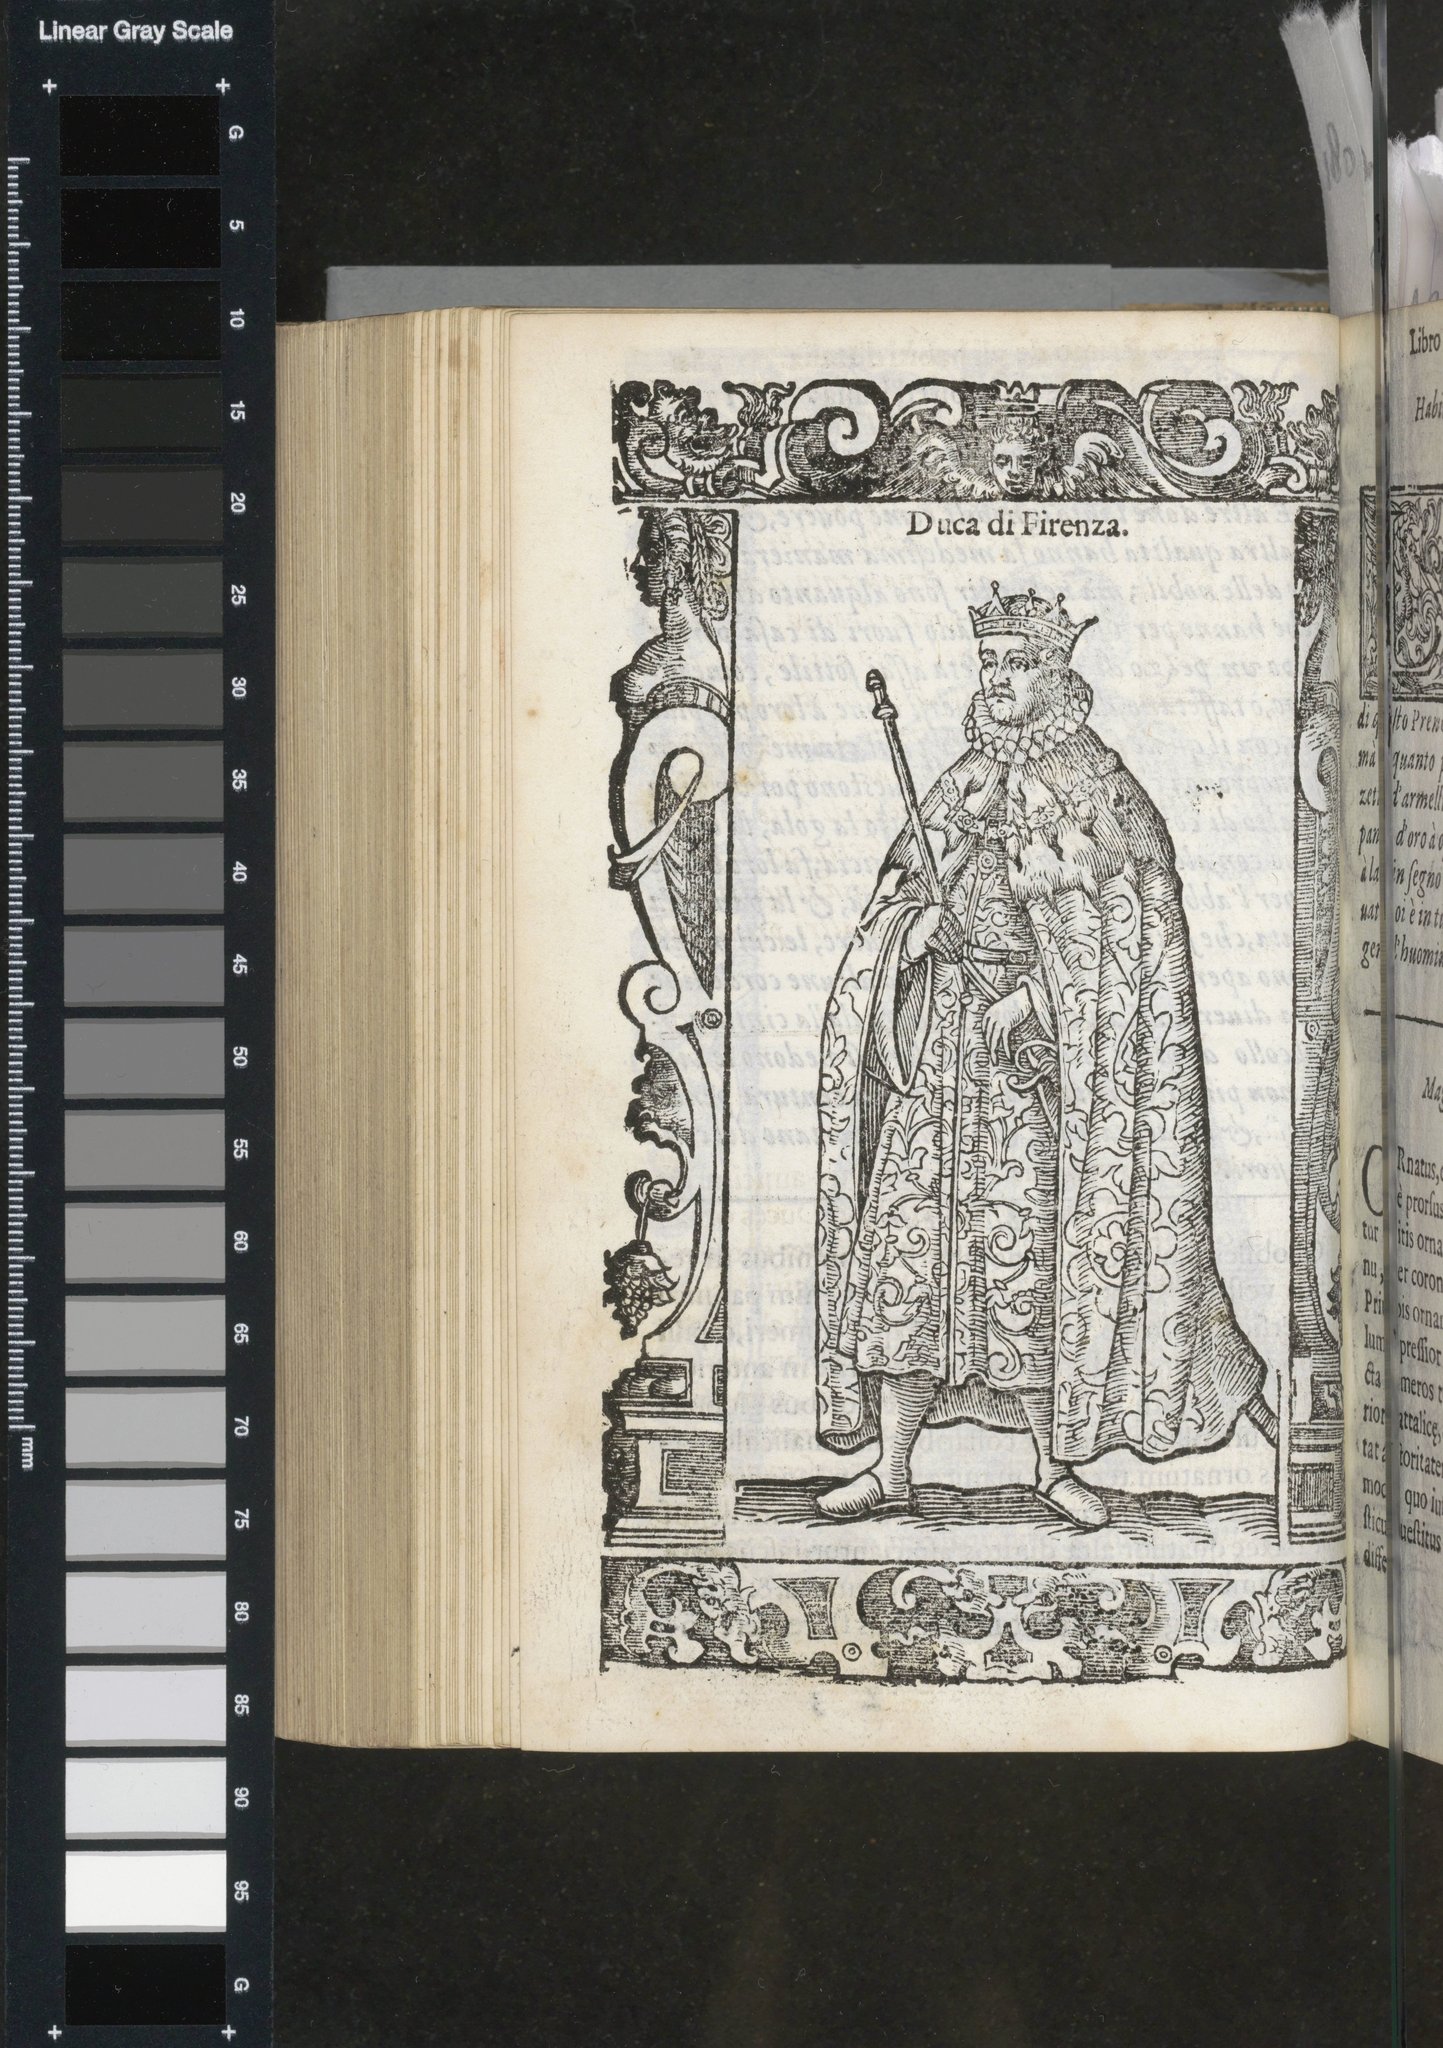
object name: costume print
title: Habiti antichi, et moderni di tutto il mondo...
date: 1598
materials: paper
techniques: woodcut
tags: fashion plates